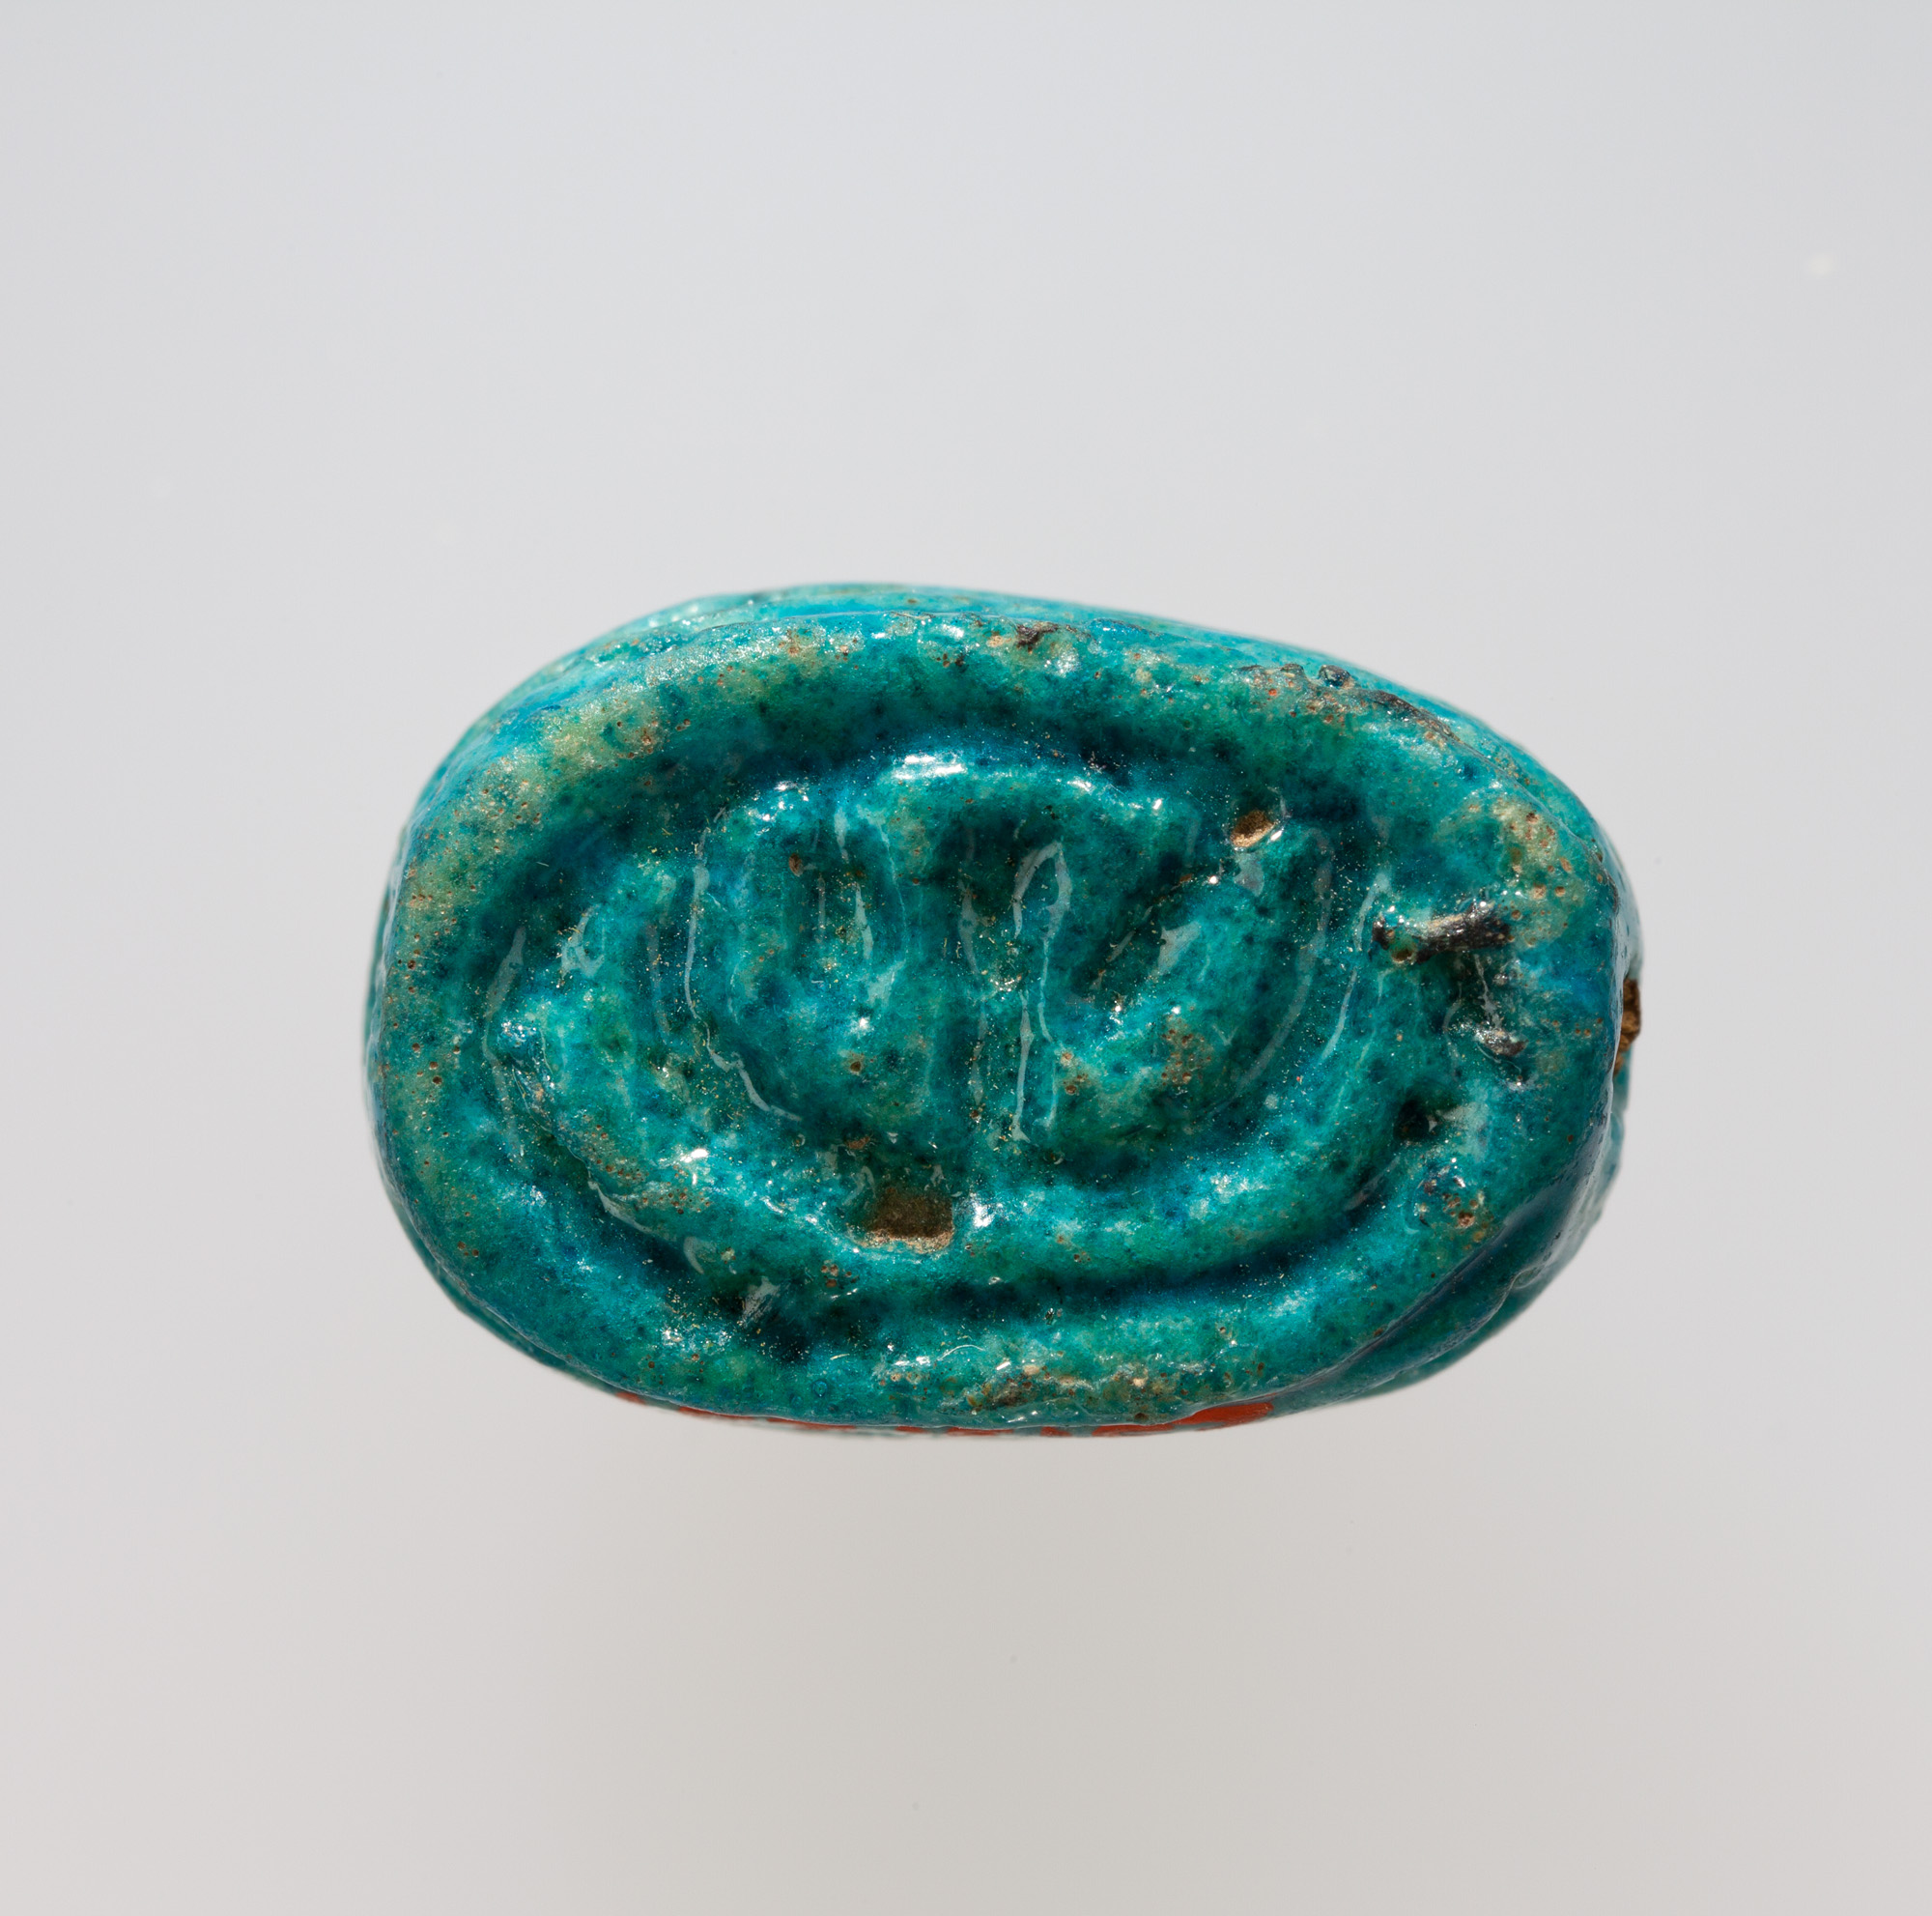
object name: scarab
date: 1479-1458 BCE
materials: faience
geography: egypt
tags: scarabs